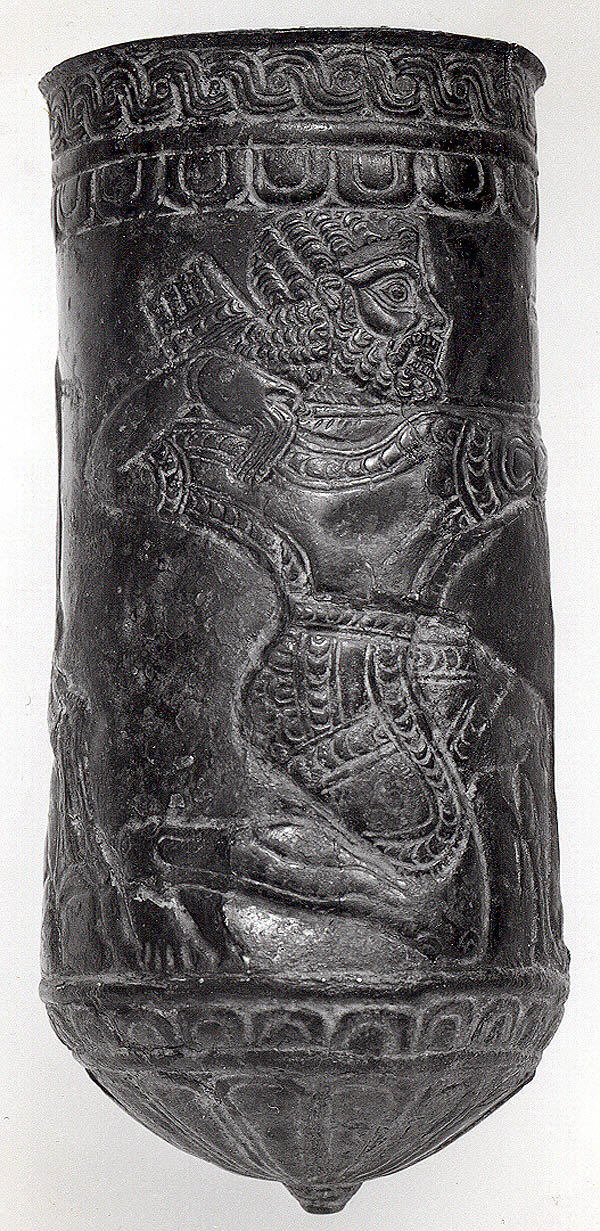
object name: beaker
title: Beaker with archer and bull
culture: iranian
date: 1000-801 BCE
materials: bronze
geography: western iran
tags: bow and arrow,men,bulls